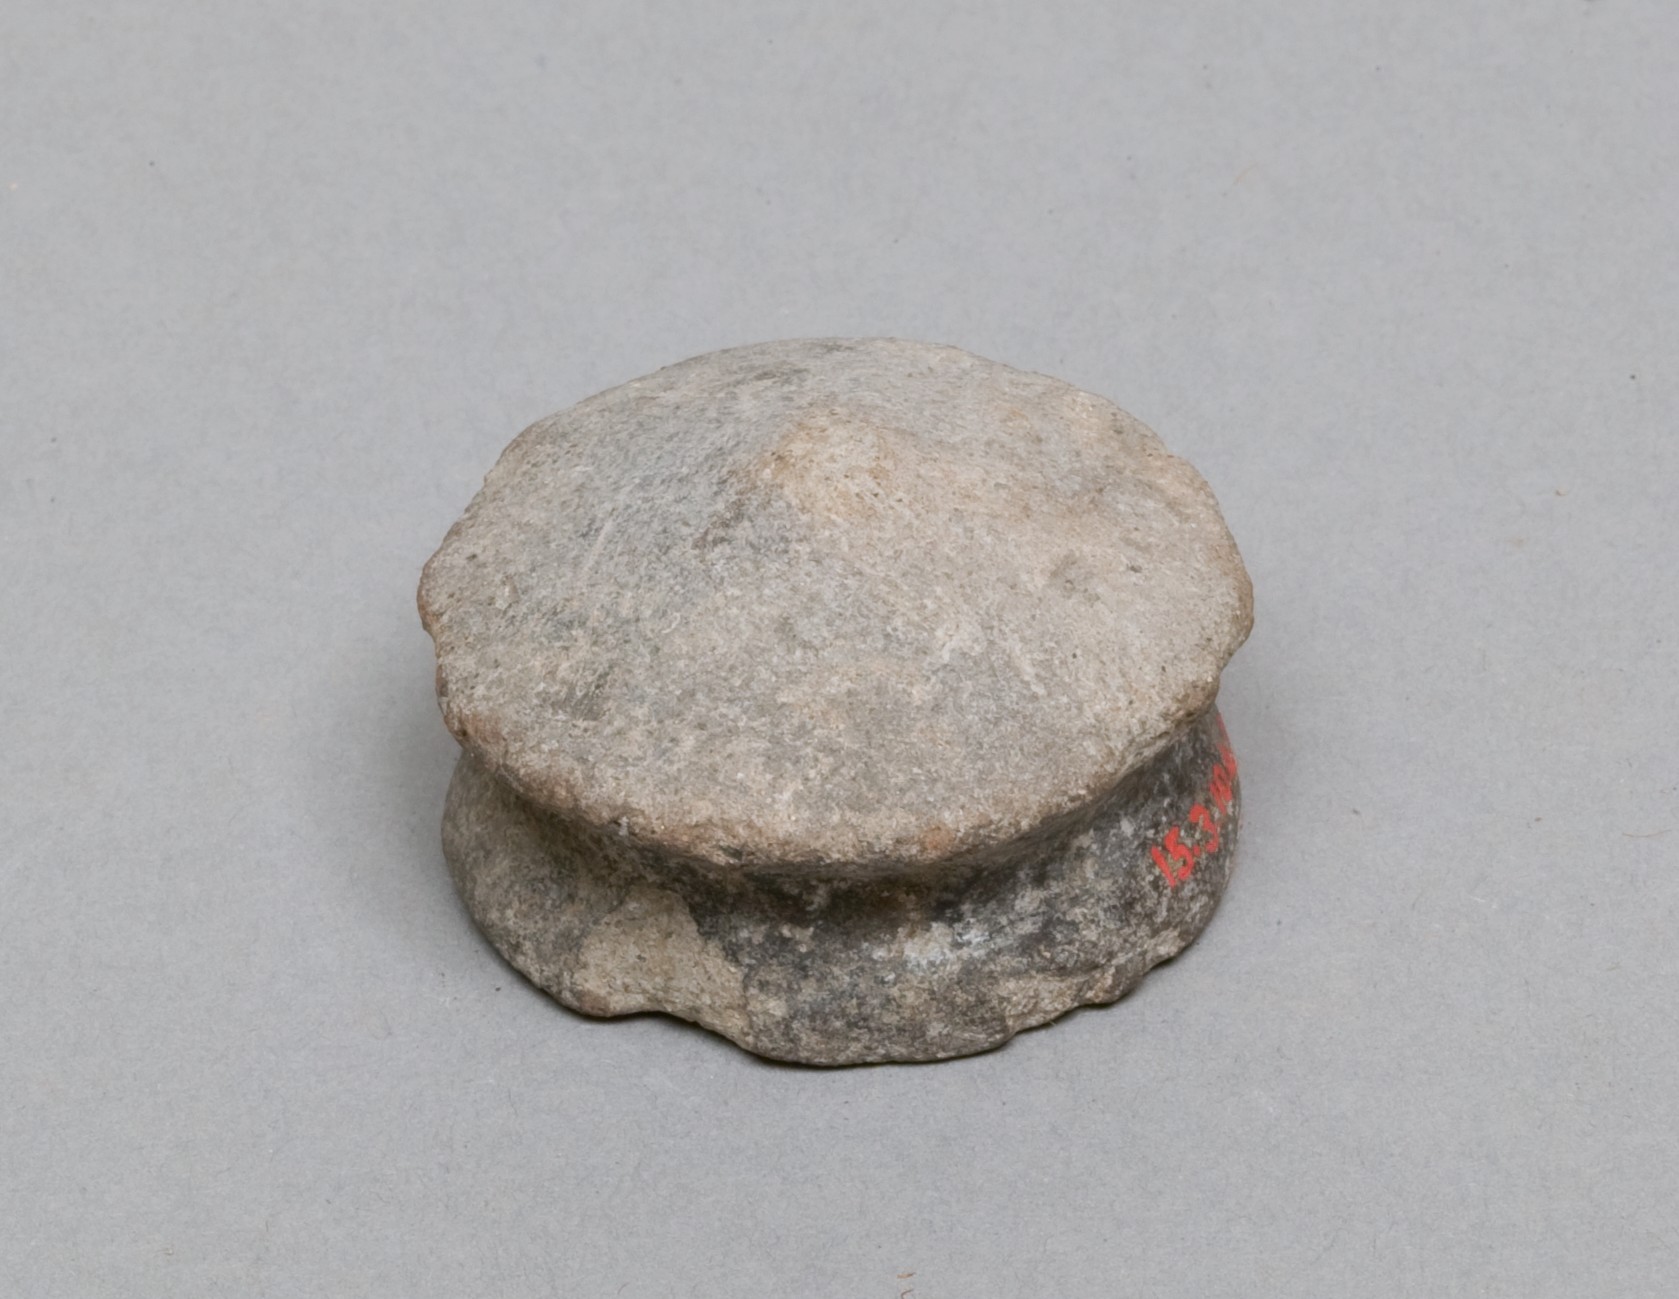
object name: reel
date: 1295-1070 BCE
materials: pottery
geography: egypt